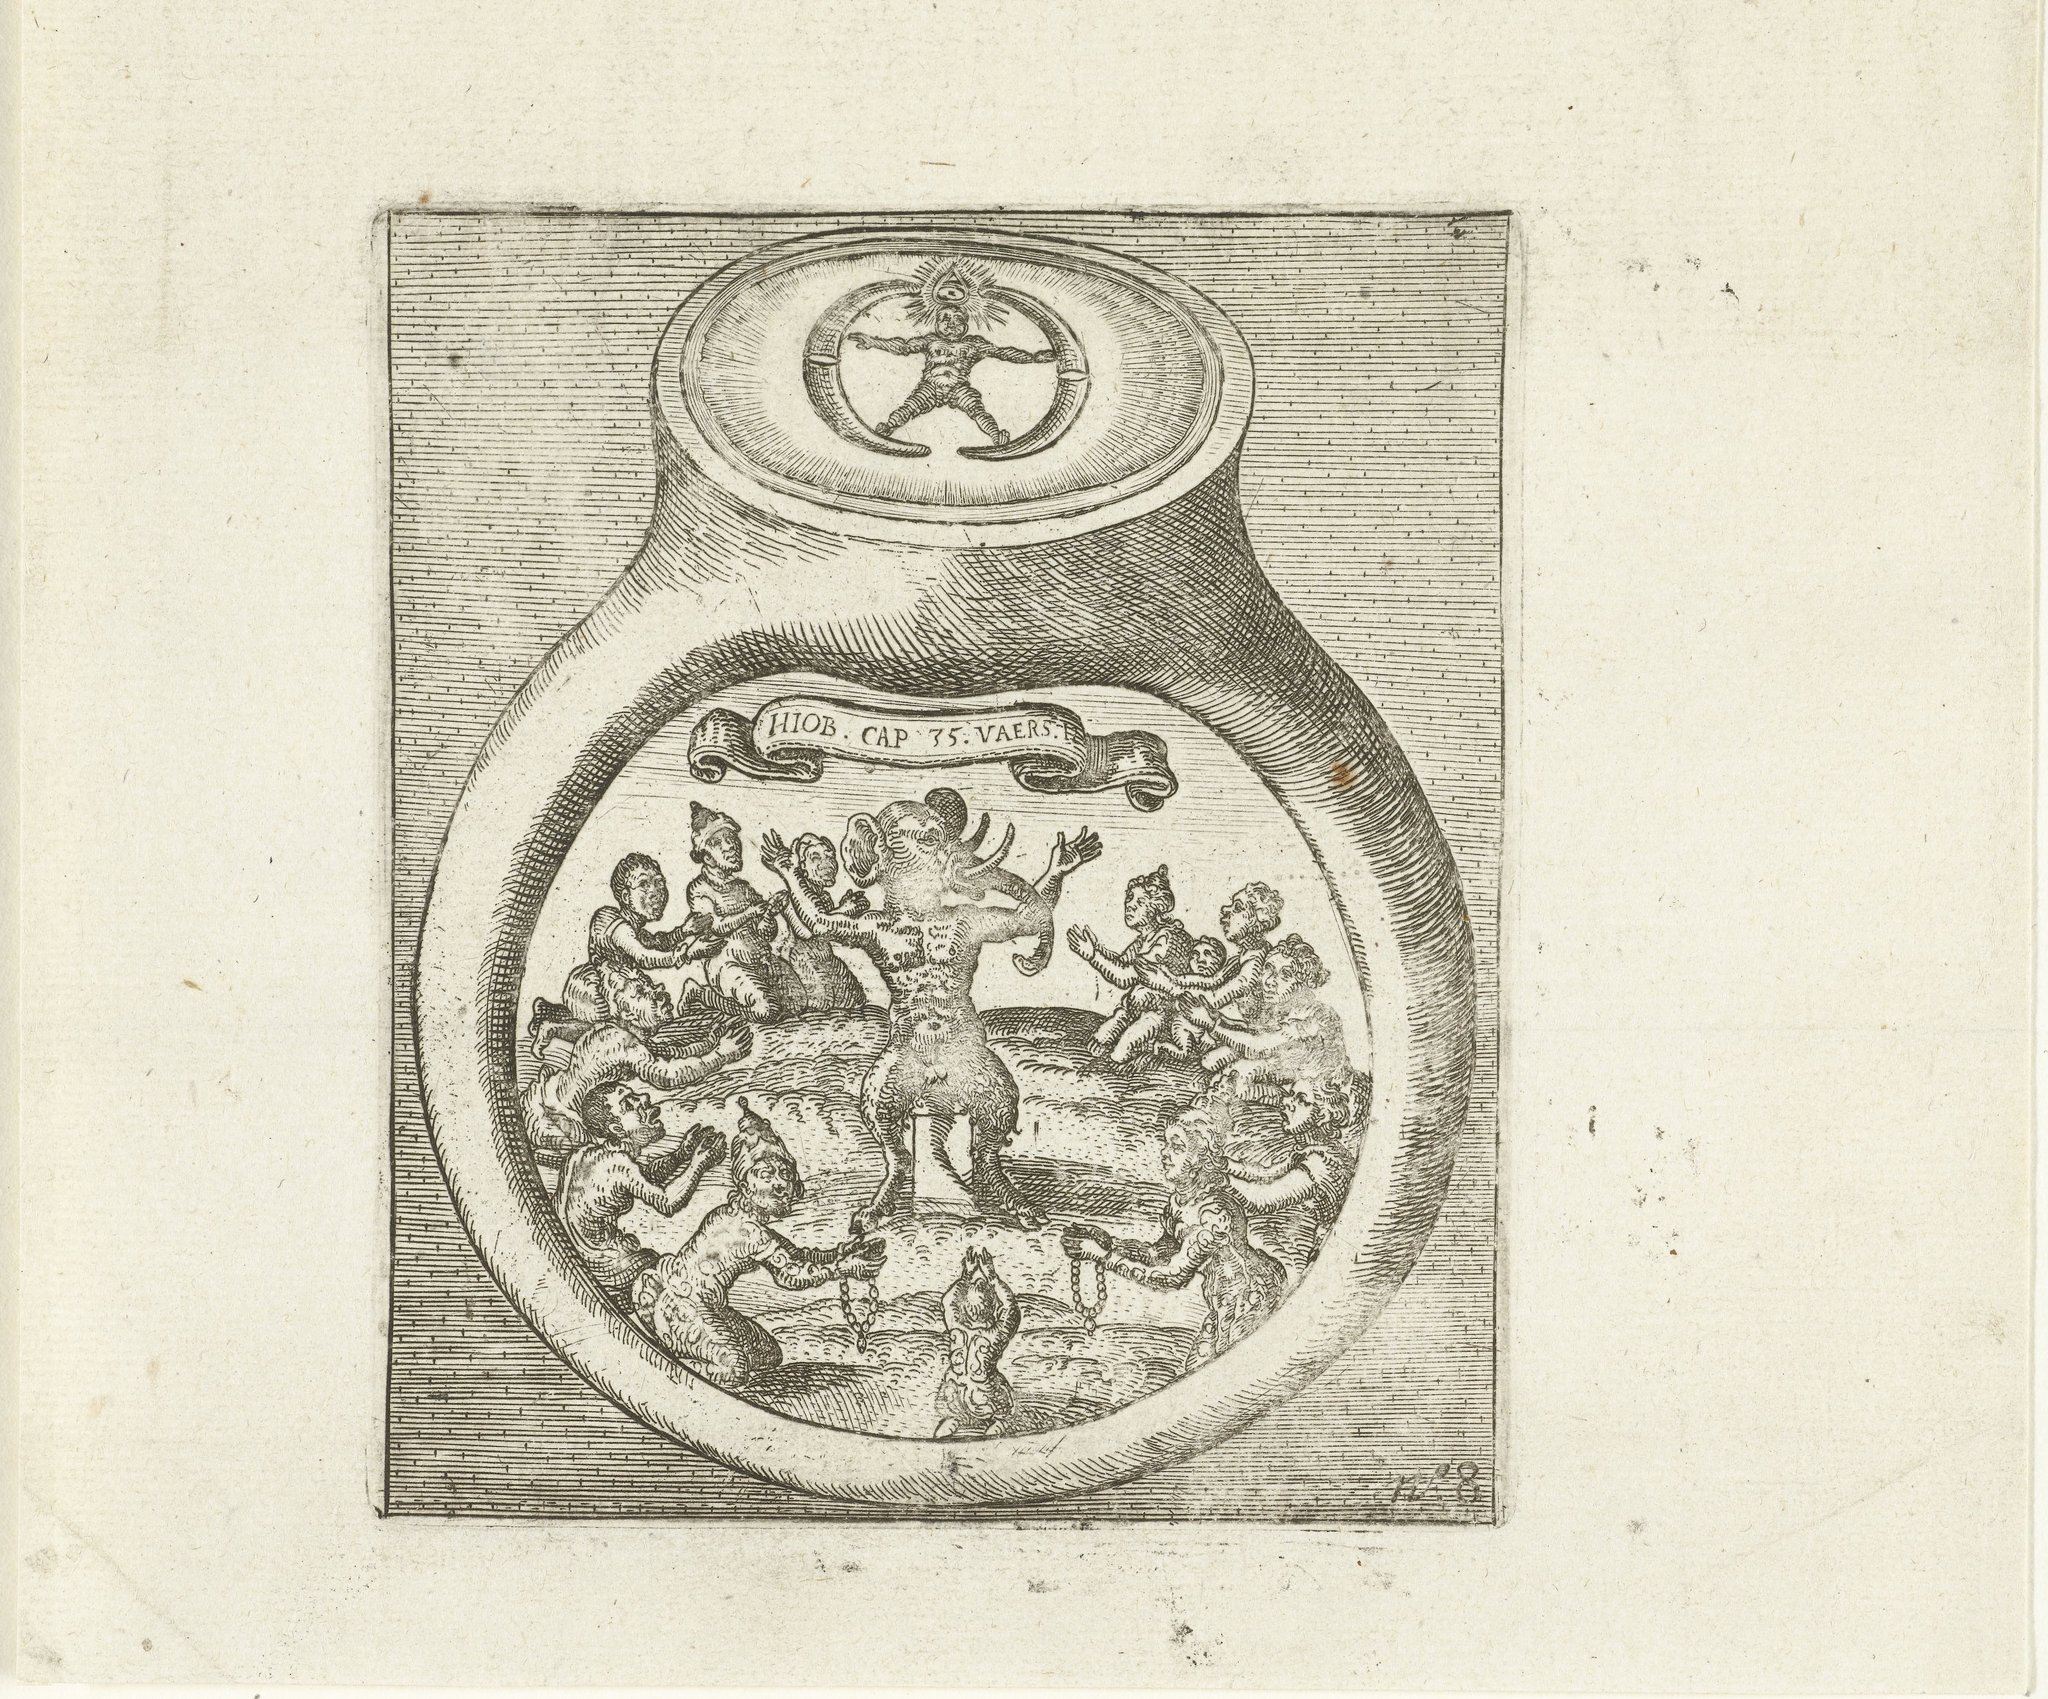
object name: print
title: Zegelring en aanbidding van de god Ganesha op Ceylon, 1602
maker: floris balthasarsz. van berckenrode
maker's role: print maker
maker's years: 1562-1616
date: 1603-1605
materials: paper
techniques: engraving, etching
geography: northern netherlands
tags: antwerp, bergen op zoom, landscapes in tropical and sub-tropical regions, exploration, expedition, voyage of discovery, representations ~ goddesses, demi-goddesses, heroines etc. (hinduism, buddhism or jainism), sri lanka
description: Gebruikt als illustratie eerst in: J. van Spilbergen, t'Historiael iournael, van tghene ghepasseert is van weghen drie schepen (...) onder tbeleyt van Ioris van Speilberghen generael, anno 1601 (...) tot in t'eylant Celon, Floris Balthasars, Delft, 1605. In deze staat gebruikt als illustratie in: 't Historiael Journael, van tghene ghepasseert is van weghen drie Schepen ghenaemt den Ram, Schaep, ende het lam, ghevaren uyt Zeelandt, van der Stadt Camp-Vere, naer d'Oost-Indien, onder 't beleyt van den heer Admirael Joris van Splibergen, gedaen in de Jaren 1601. 1602. 1603. ende 1604. Opgenomen in: I. Commelin, Begin ende voortgangh, van de Vereenighde Nederlantsche Geoctroyeerde Oost-Indische Compagnie, J. Janssonius, Amsterdam 1646. Genummerd: No. 8.